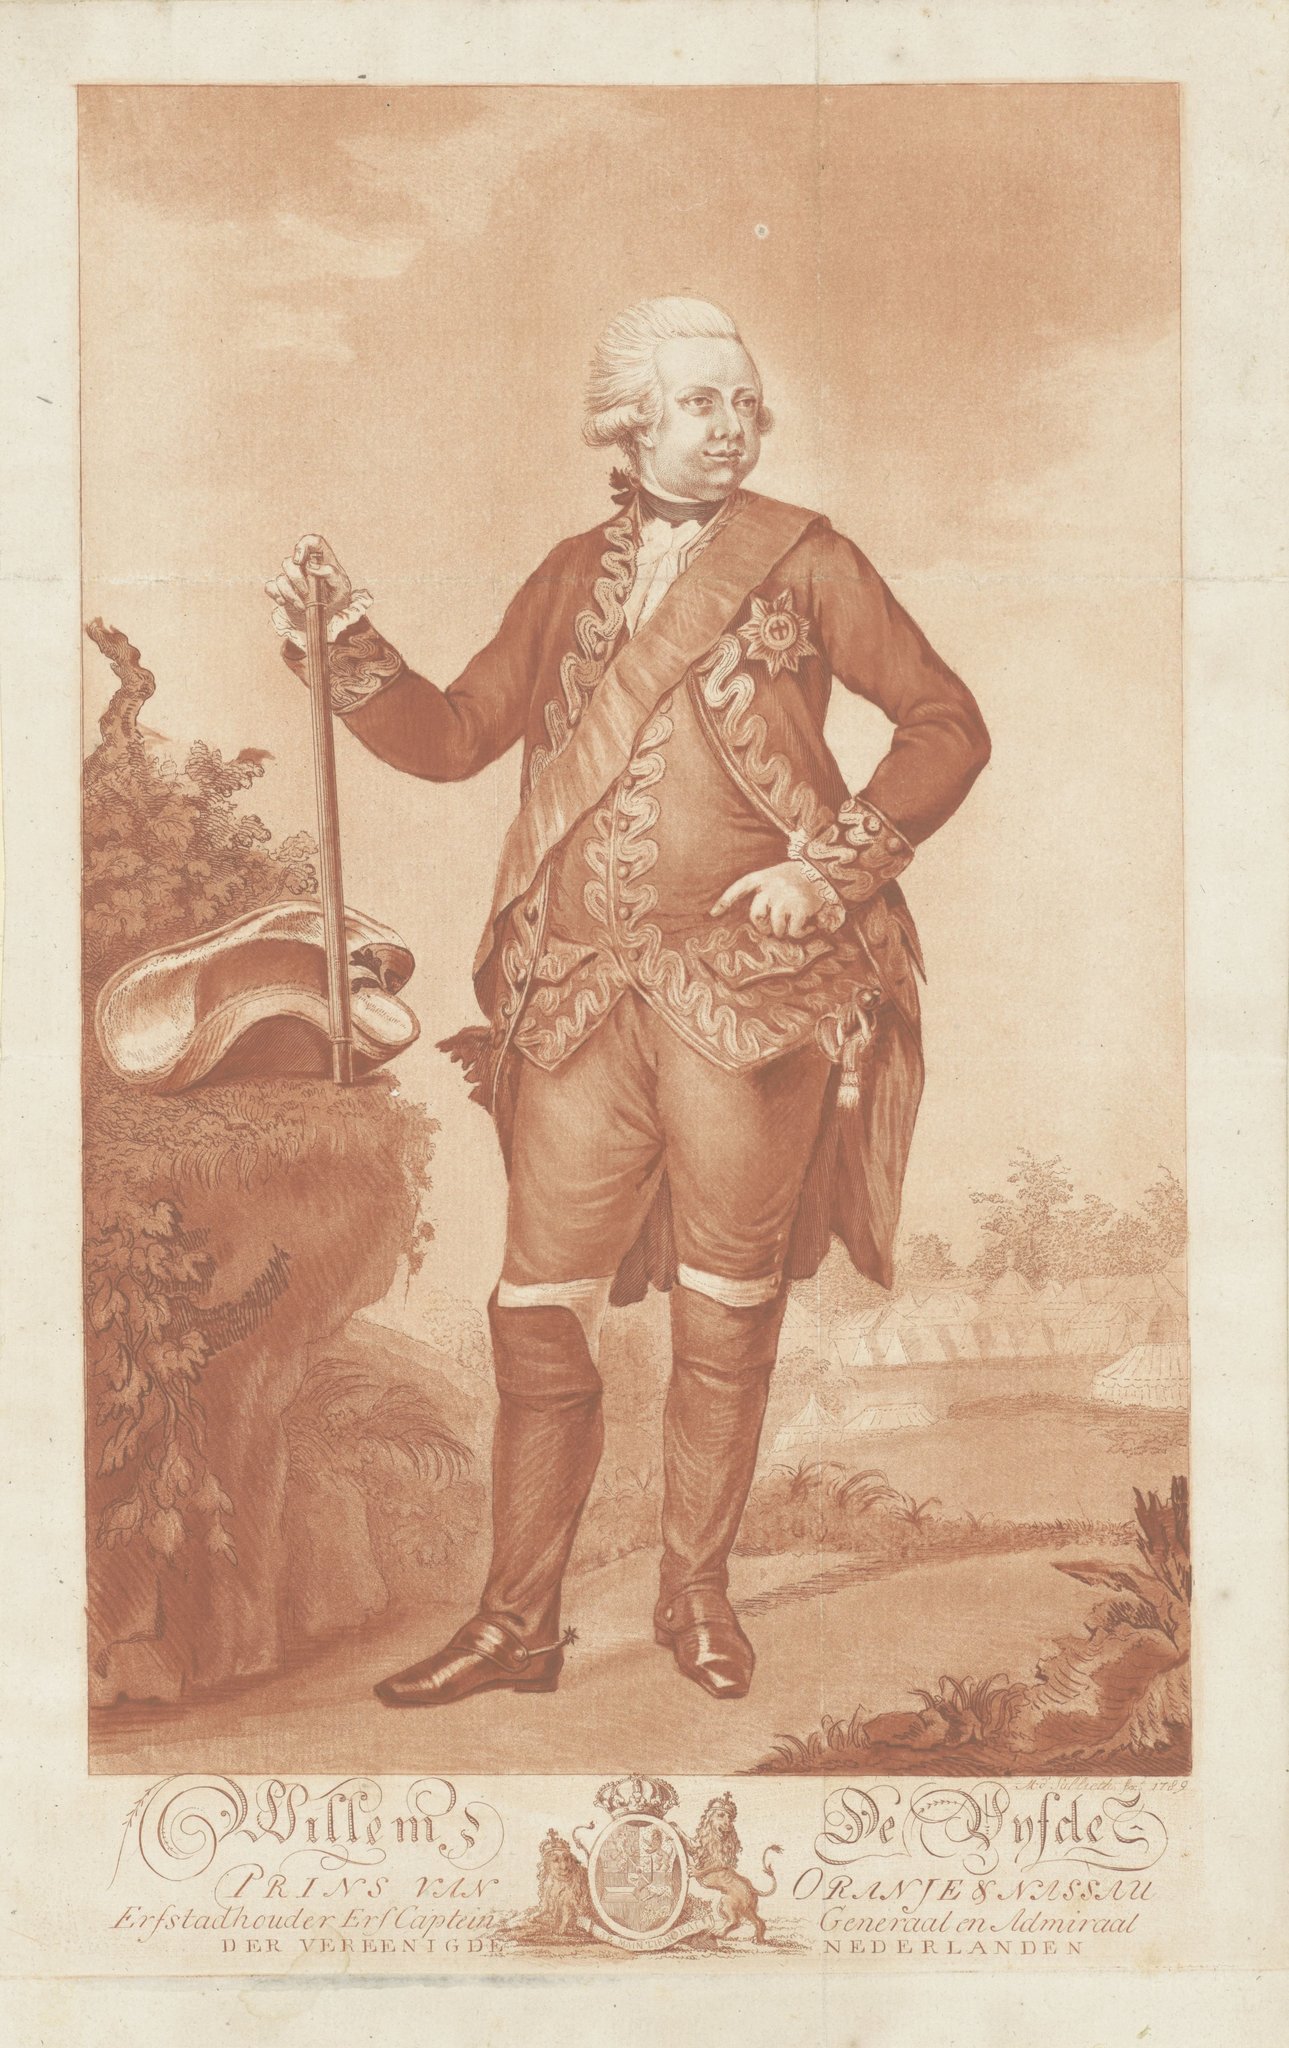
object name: print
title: Portret van Willem V, prins van Oranje-Nassau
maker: mathias de sallieth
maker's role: print maker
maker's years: 1749-1791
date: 1789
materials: paper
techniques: aquatint, engraving, etching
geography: northern netherlands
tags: the hague, william v (prince of orange)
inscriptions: date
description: Portret van Willem V. In zijn rechterhand een commandostaf. Op de achtergrond een legerkamp. Midden onder zijn wapen met een kroon en twee leeuwen. Daaronder op een banderol zijn geslachtsspreuk. In de ondermarge zijn naam en titels.